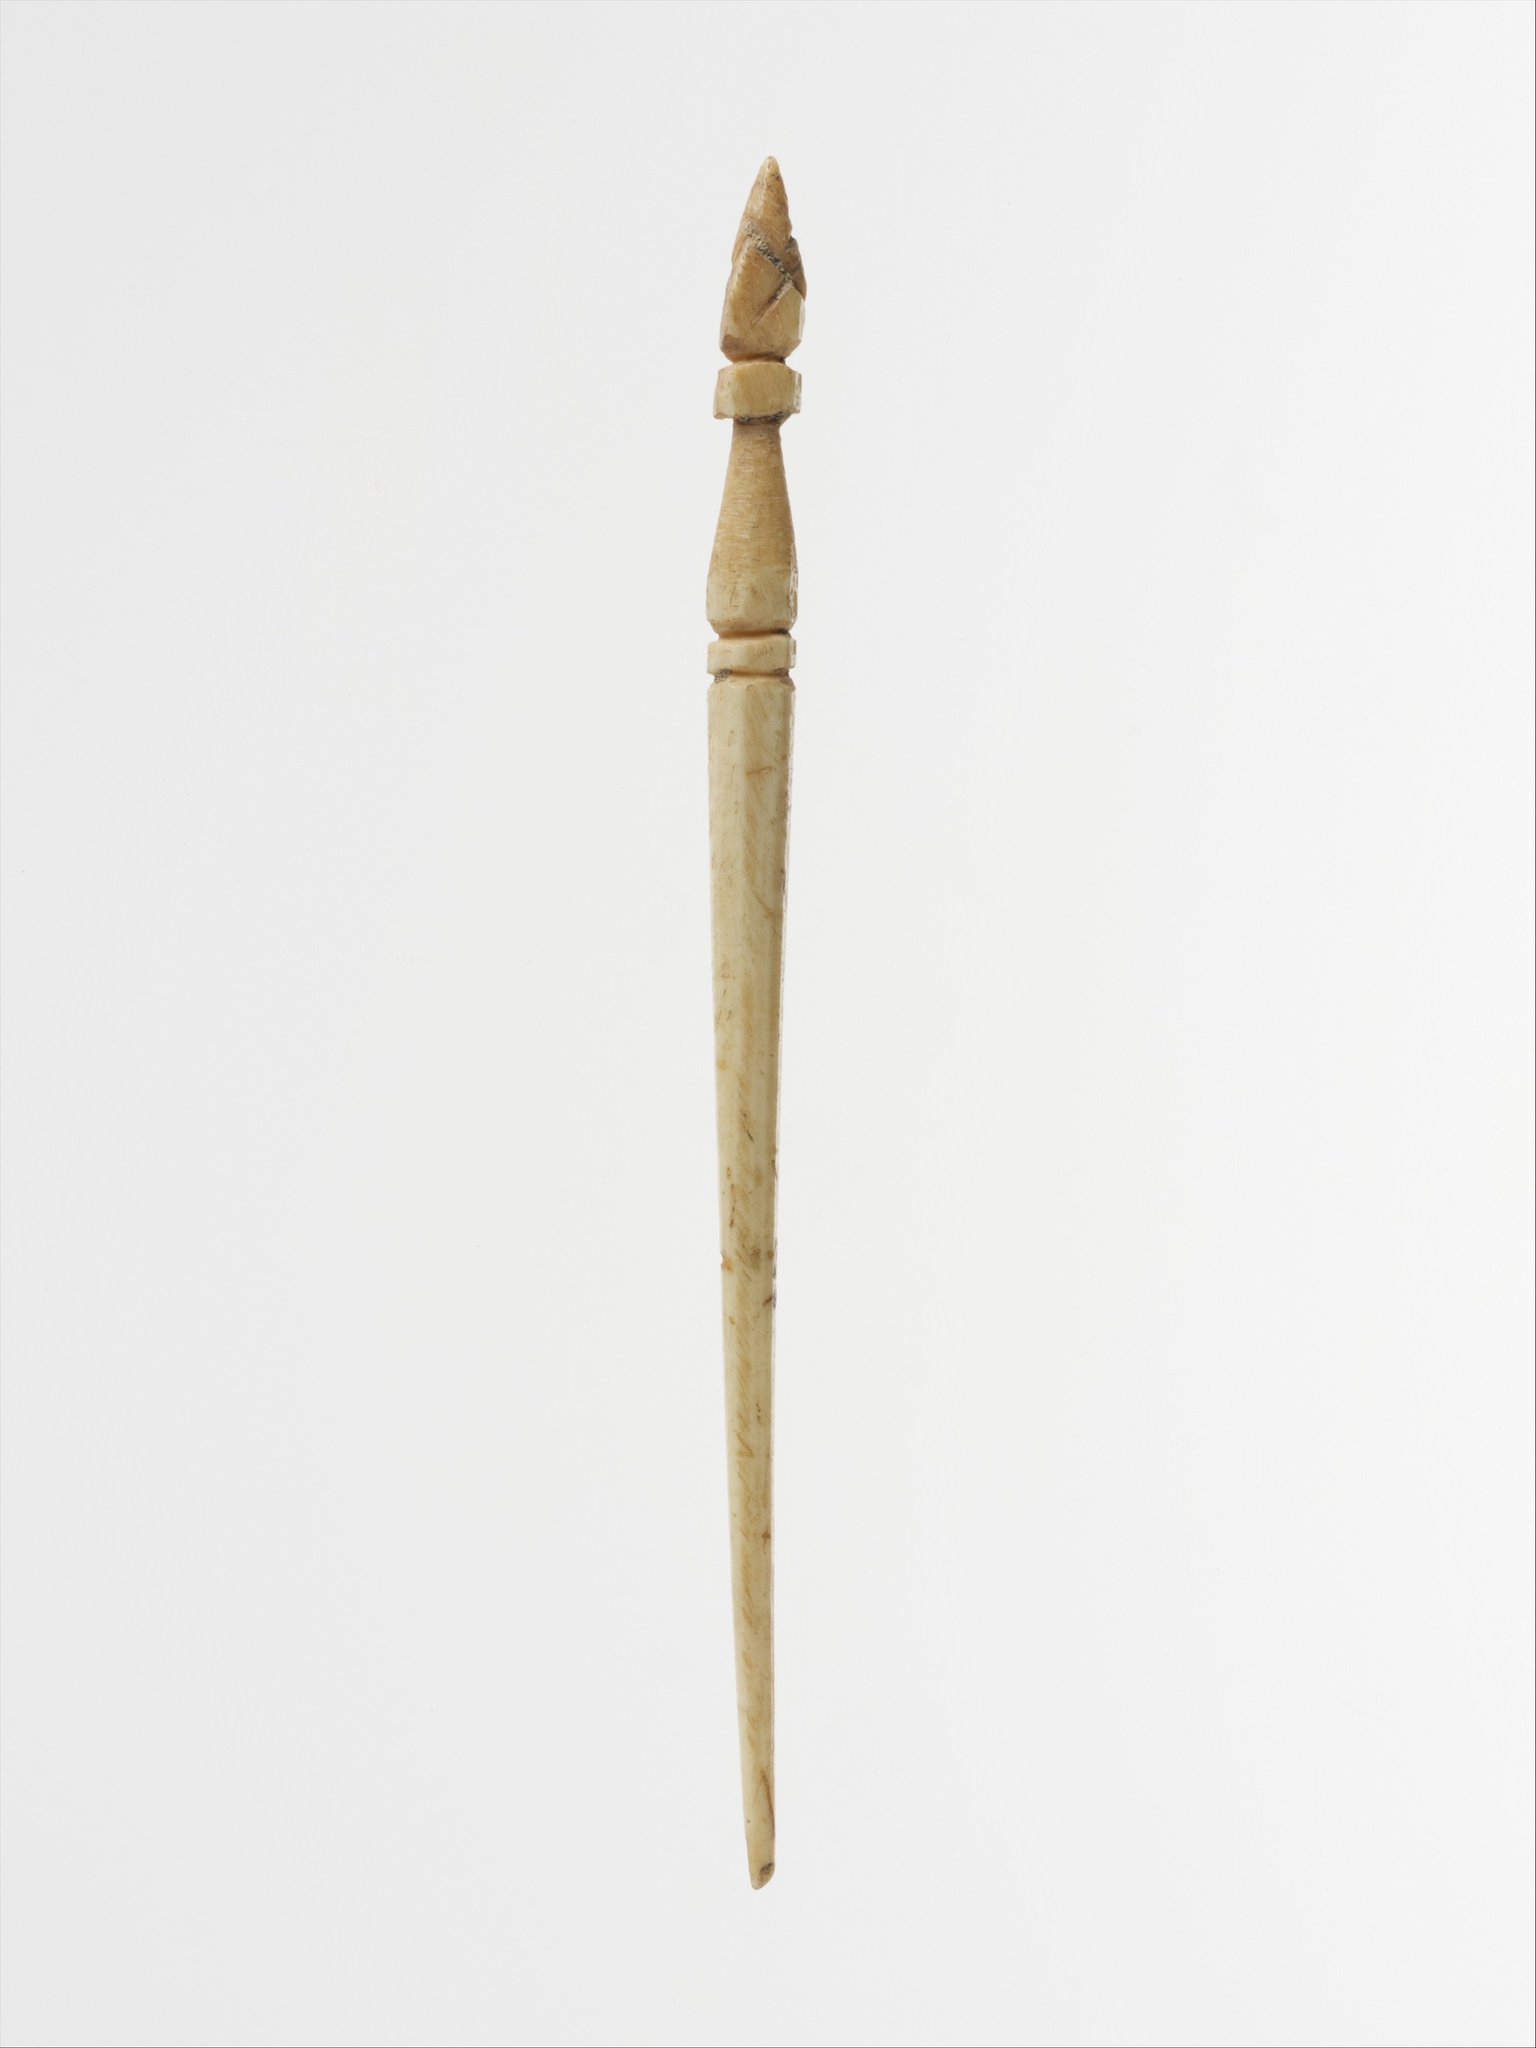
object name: pin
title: Ivory pin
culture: roman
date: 167-300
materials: ivory